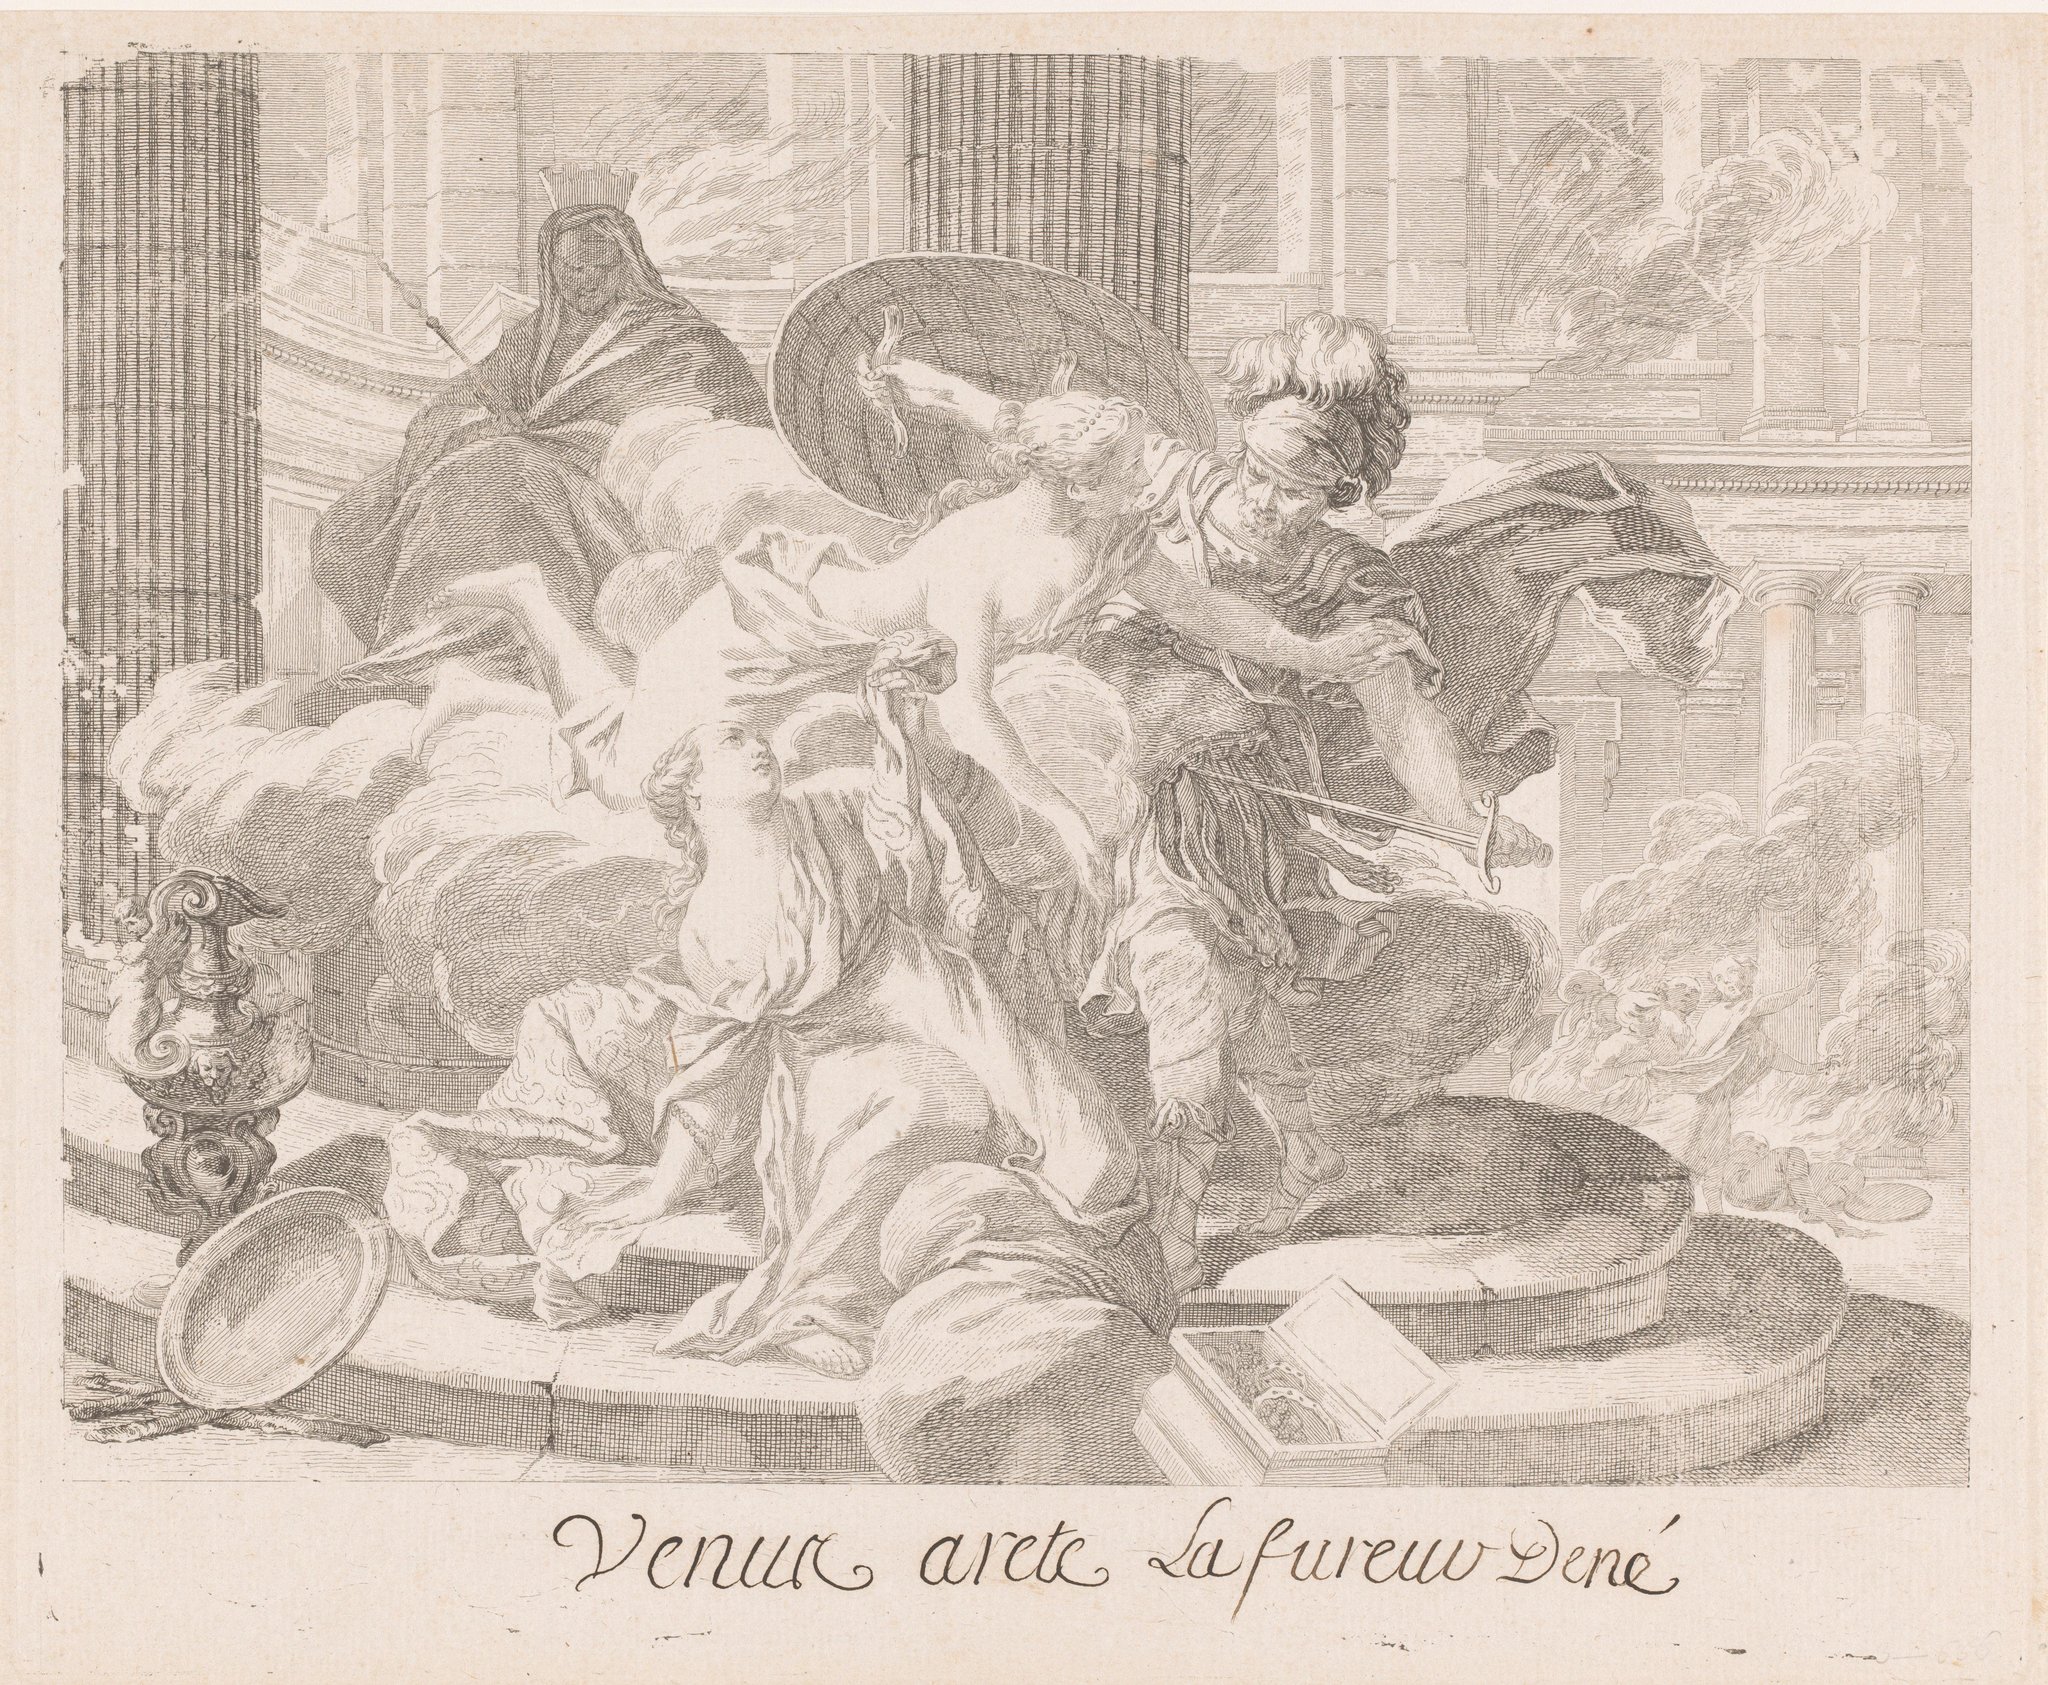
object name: print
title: Venus in gevecht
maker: Anonymous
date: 1600-1700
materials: paper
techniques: engraving, etching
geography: france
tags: (story of) venus (aphrodite)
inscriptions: collector's mark: Lugt 240, watermark, title: ‘Venus arete La fureur Dené’